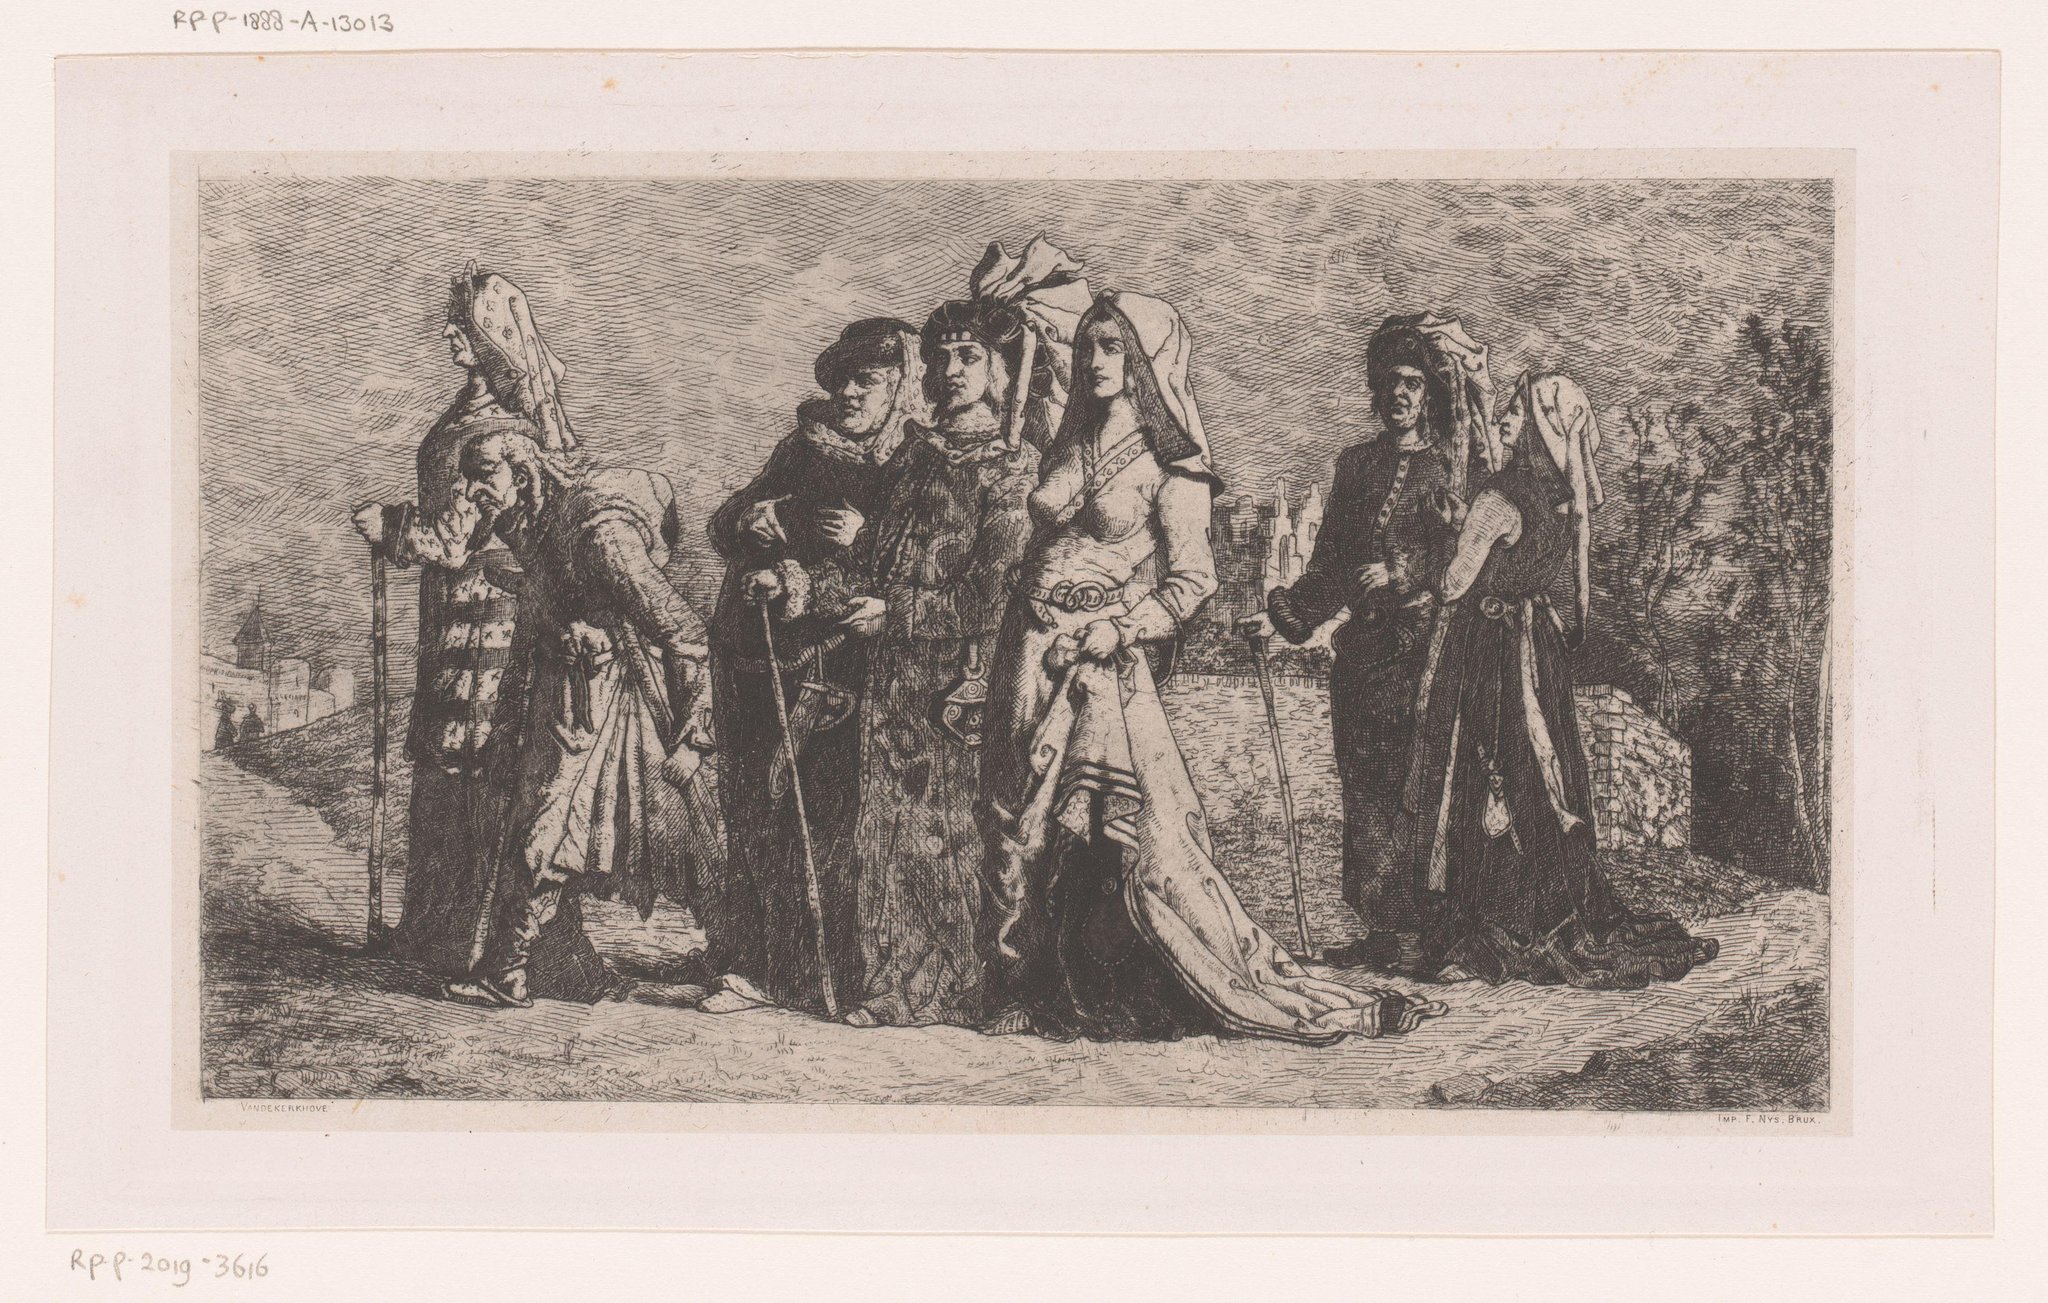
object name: print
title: Stoet figuren in historische kleding in een landschap nabij een kasteel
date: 1840-1870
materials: paper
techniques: etching, intaglio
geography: brussels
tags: historical costume, landscape with tower or castle (+ city(-scape) with figures, staffage)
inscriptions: collector's mark: Lugt 2228